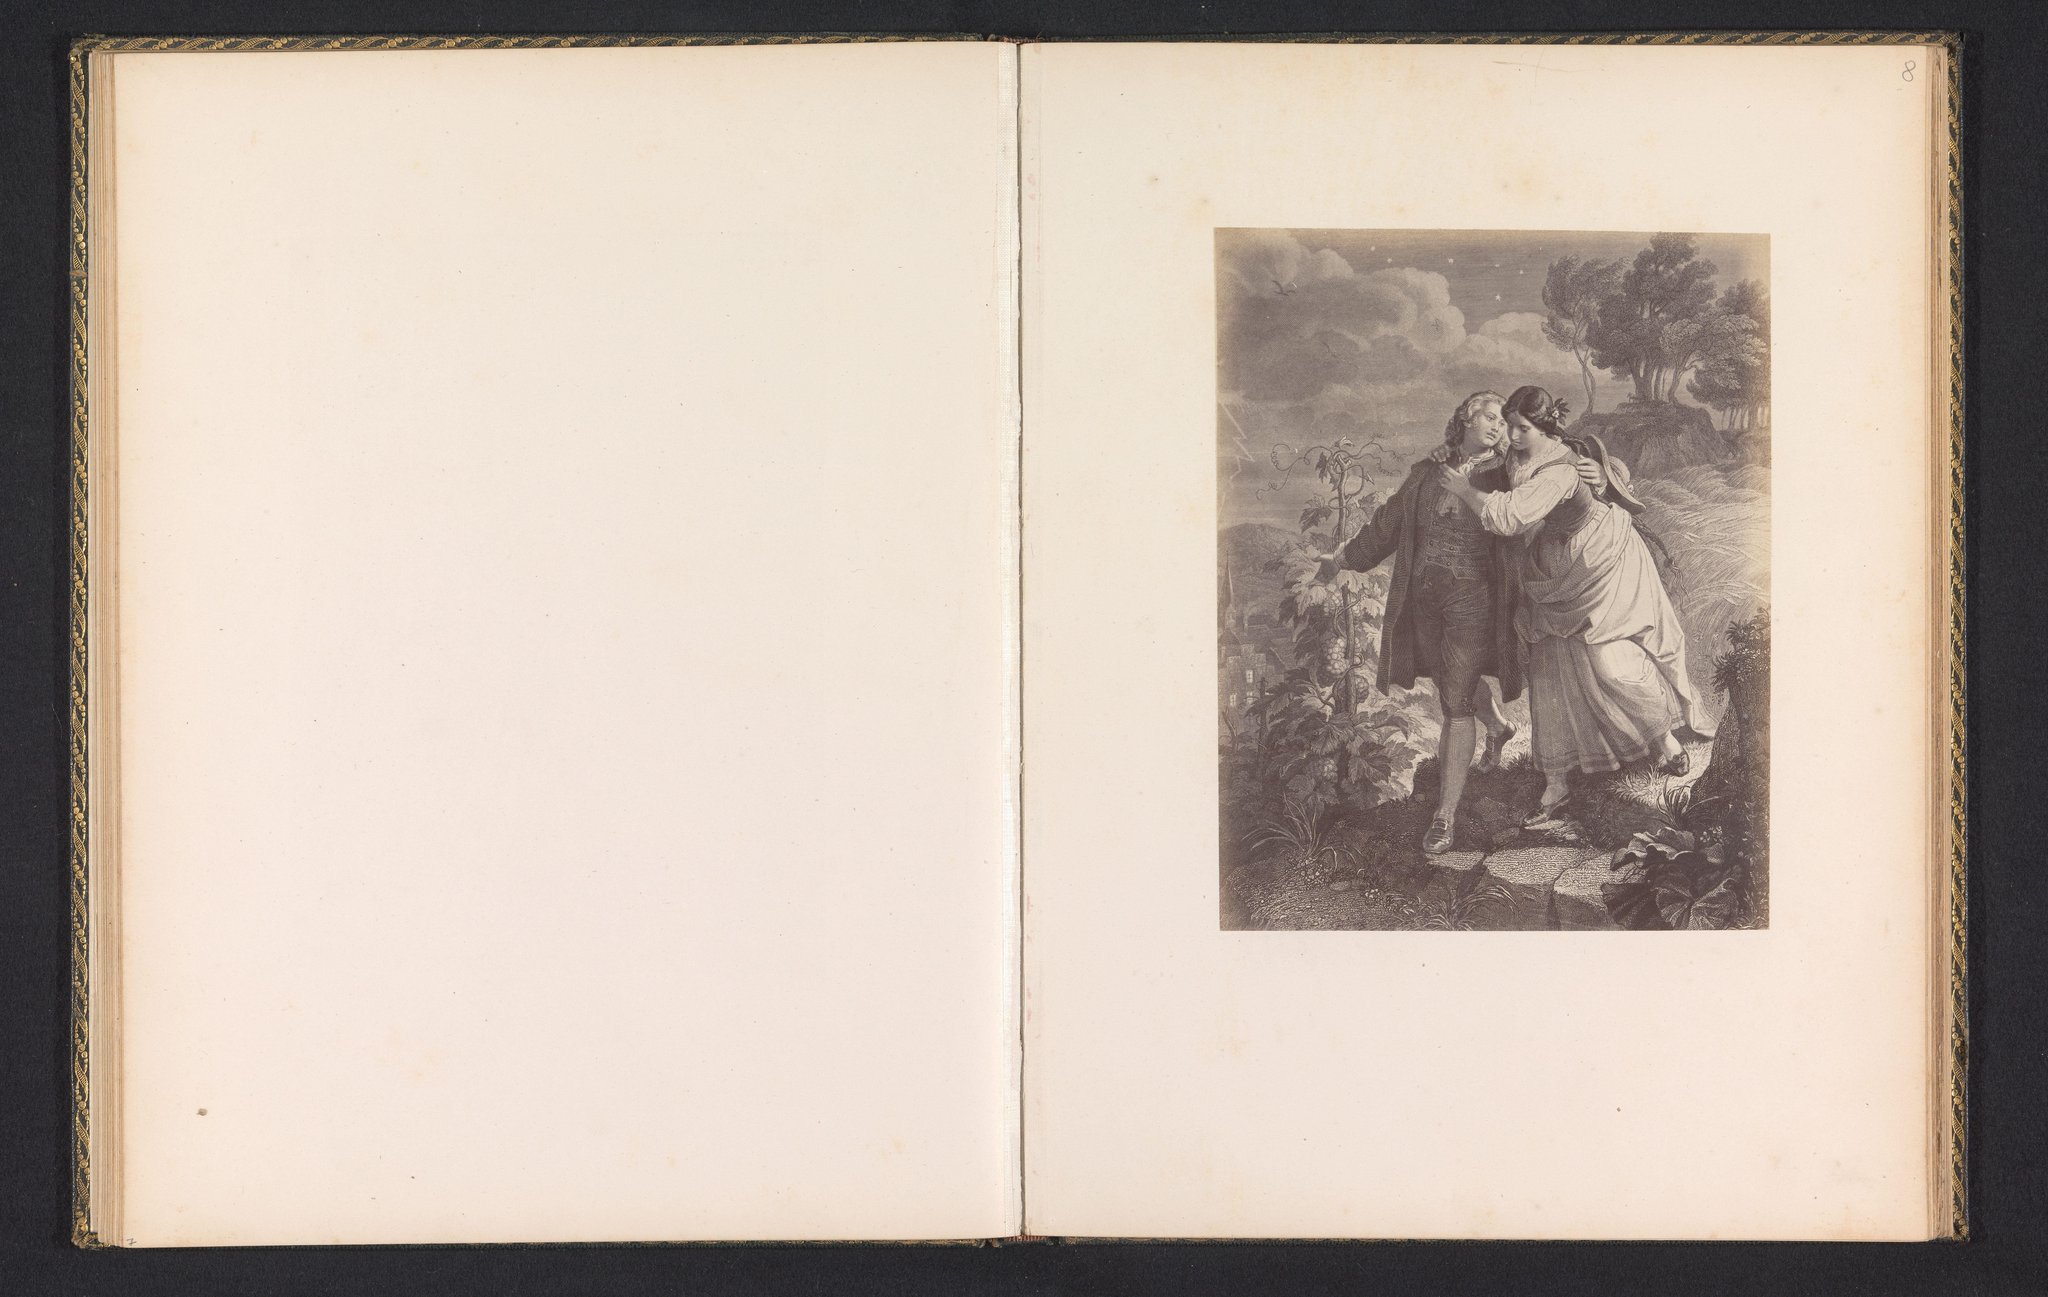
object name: photograph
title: Fotoreproductie van een prent van een scene uit Hermann und Dorothea, voorstellende Hermann en Dorothea tijdens een wandeling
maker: Anonymous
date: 1875-1885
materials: photographic support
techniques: albumen print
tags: lovers' meeting